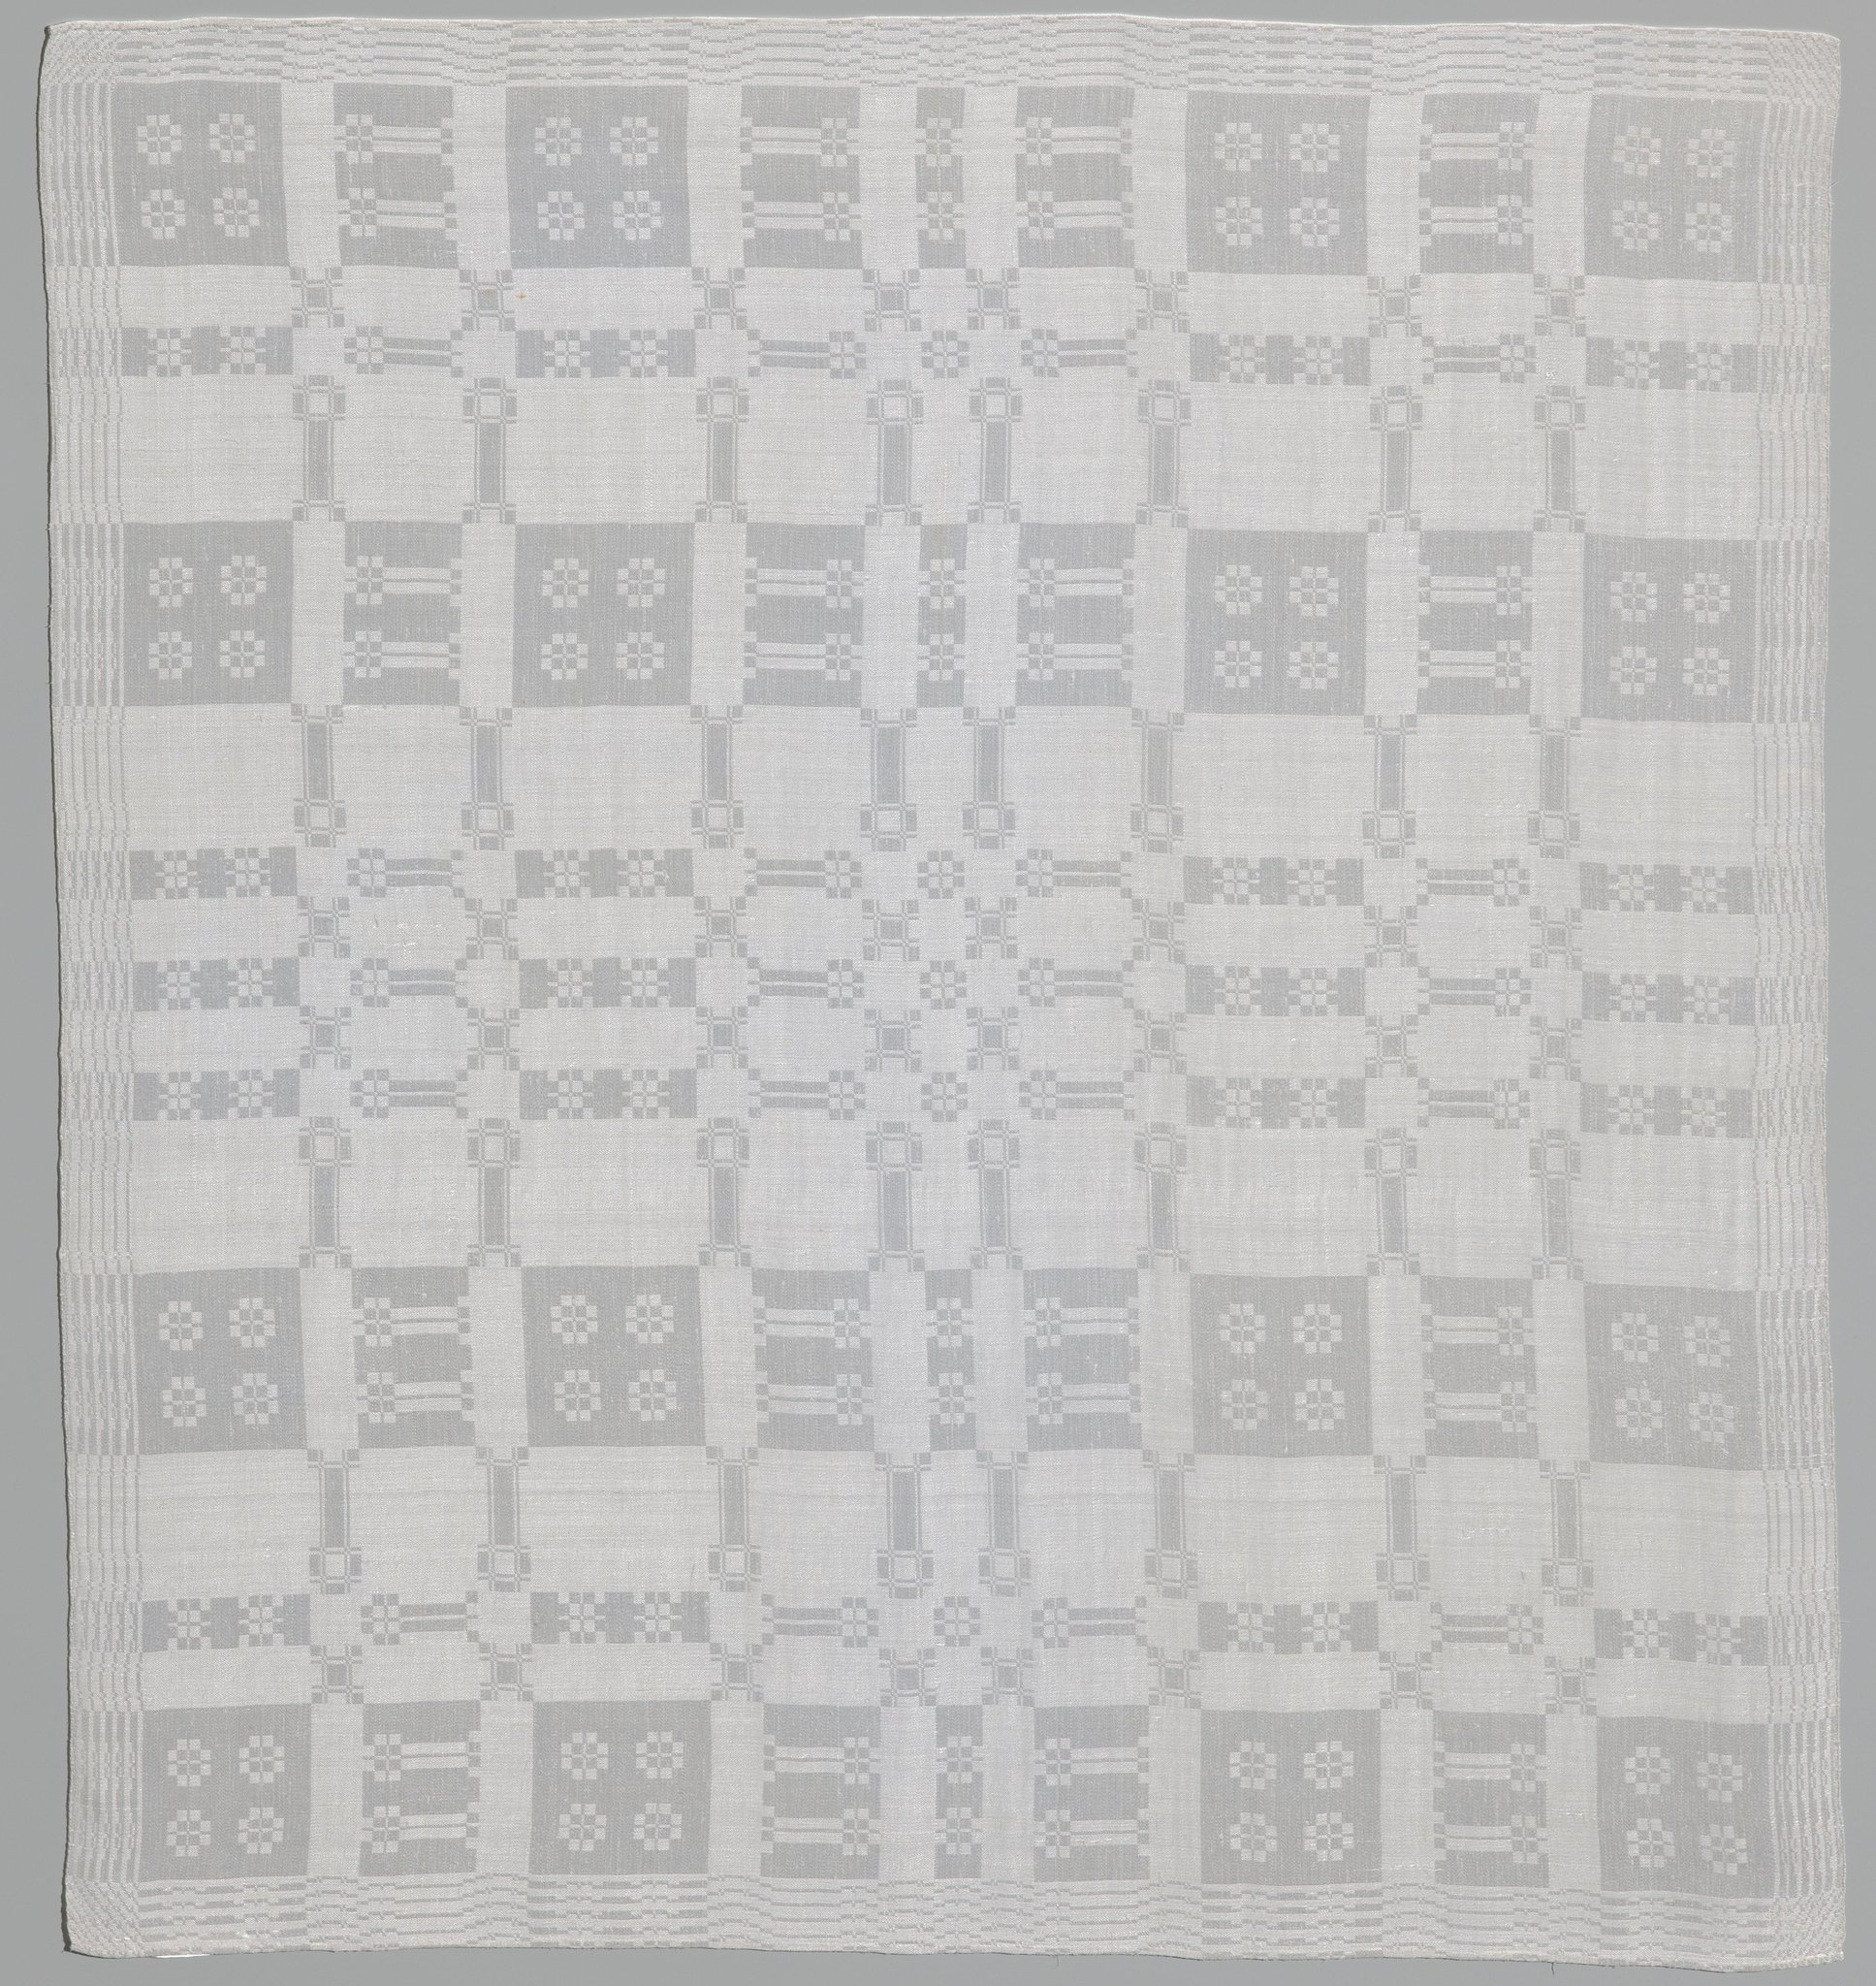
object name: handdwaal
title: Handdwaal van wit linnen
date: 1780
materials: linen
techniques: peeled fabric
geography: northern netherlands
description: Wit linnen handdwaal, pellen in kruiskeper, gemerkt HW 1.